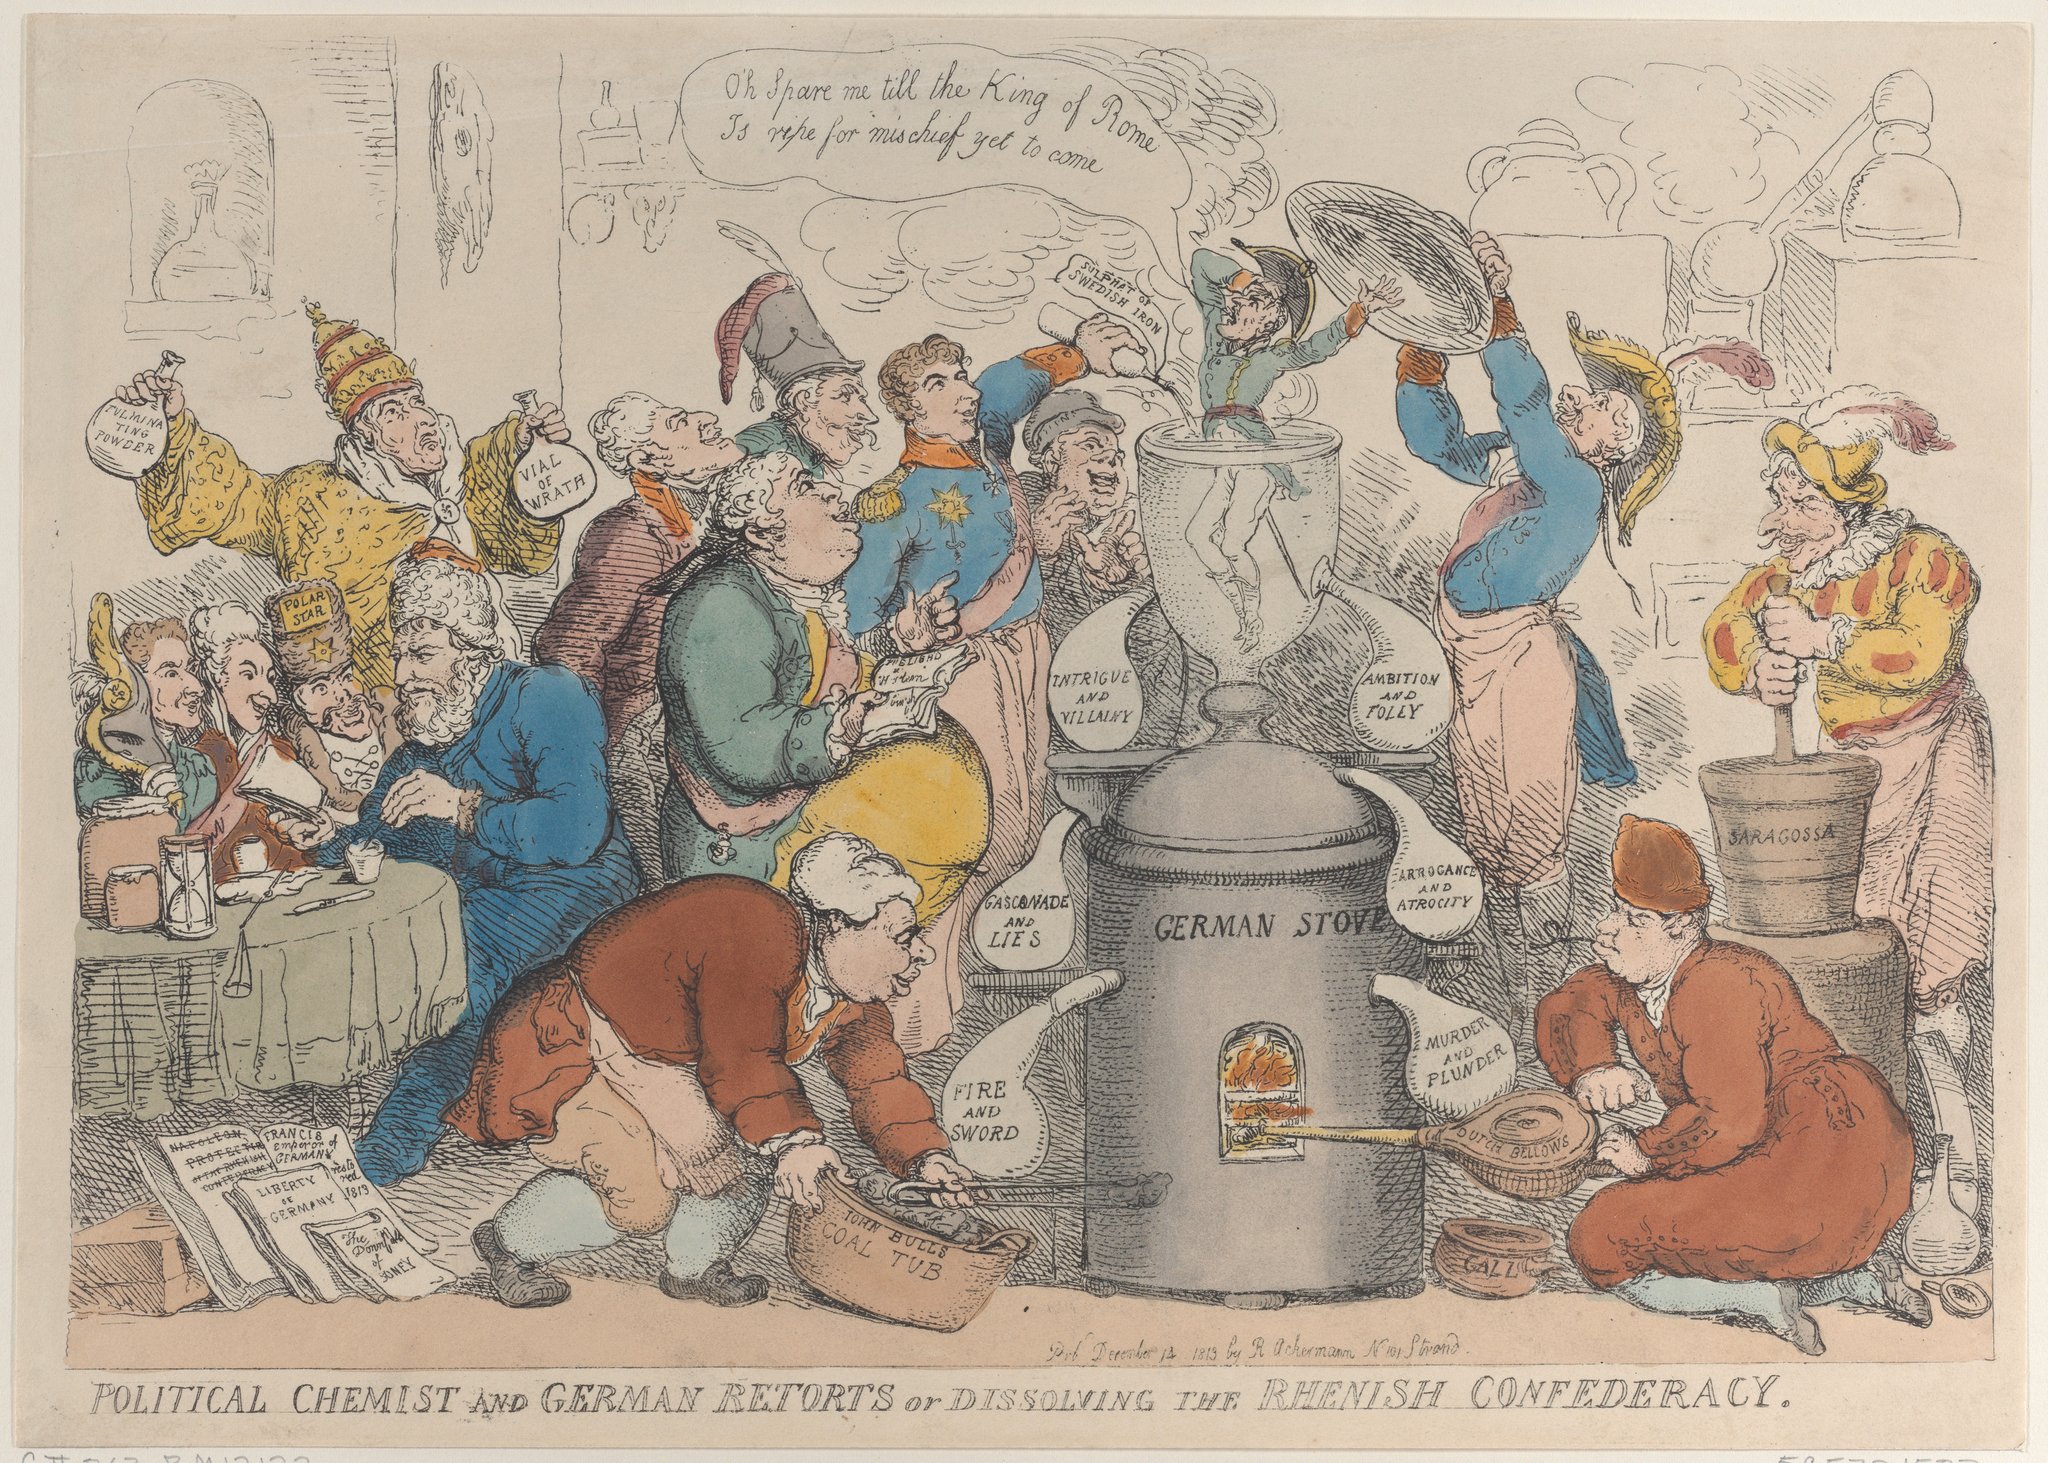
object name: print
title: Political Chemist and German Retorts or Dissolving the Rhenish Confederacy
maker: thomas rowlandson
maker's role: artist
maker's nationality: british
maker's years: 1757-1827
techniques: etching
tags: satire,napoleon i,men,politics